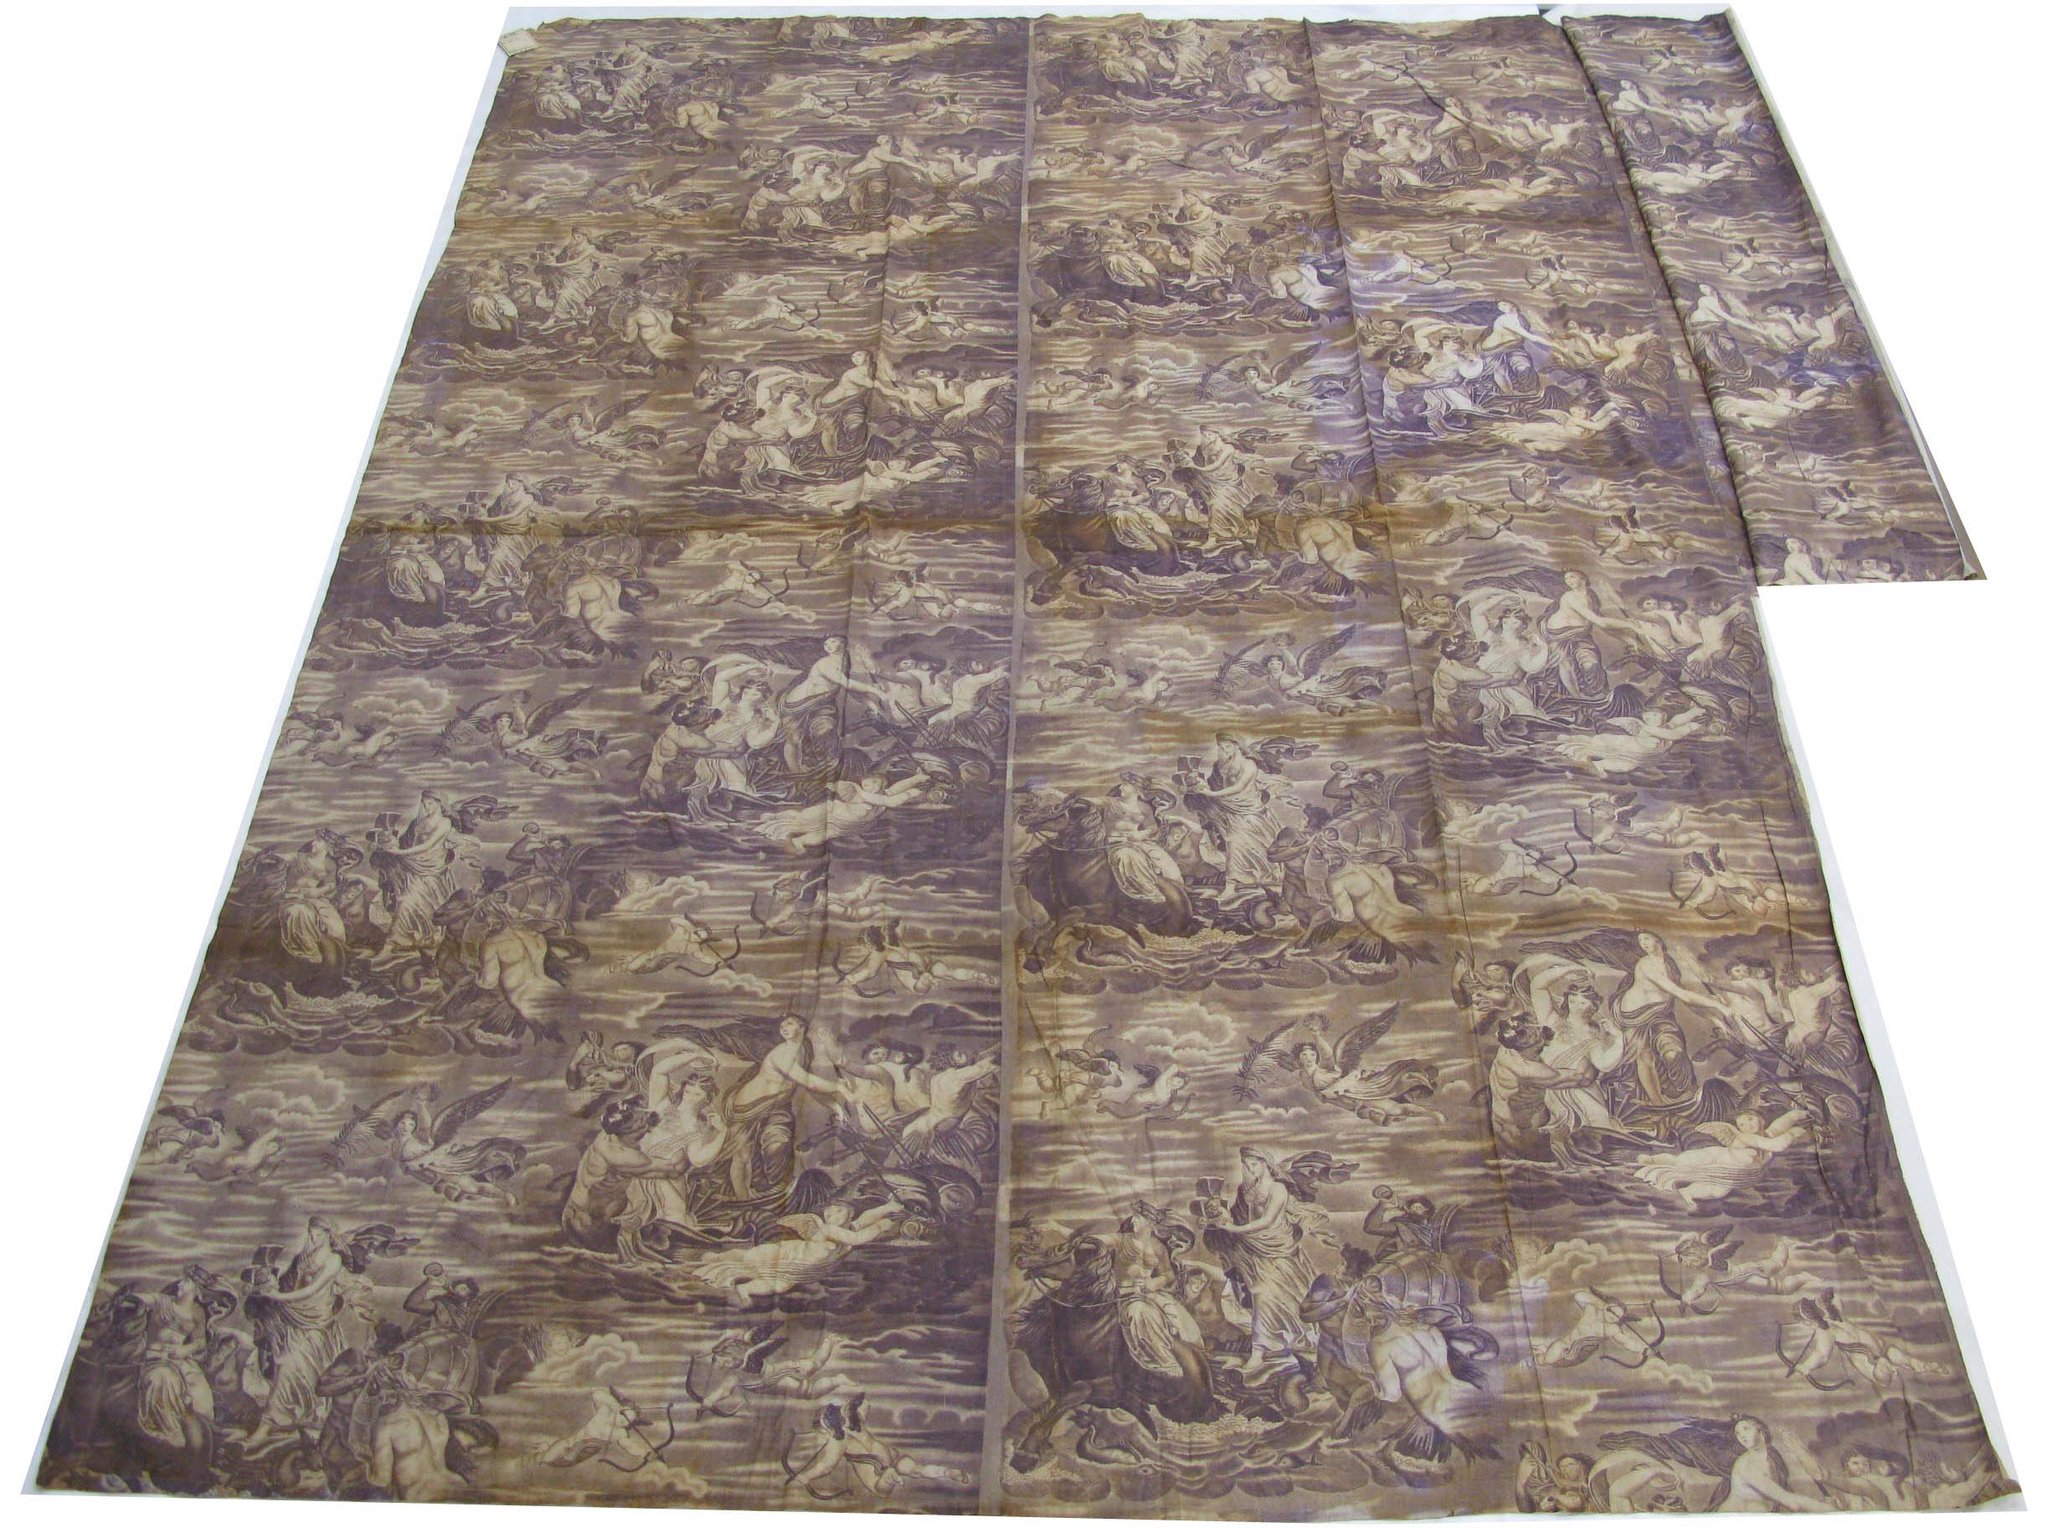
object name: length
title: The Triumph of Galatea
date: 1826-1850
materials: cotton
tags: women,galatea,putti